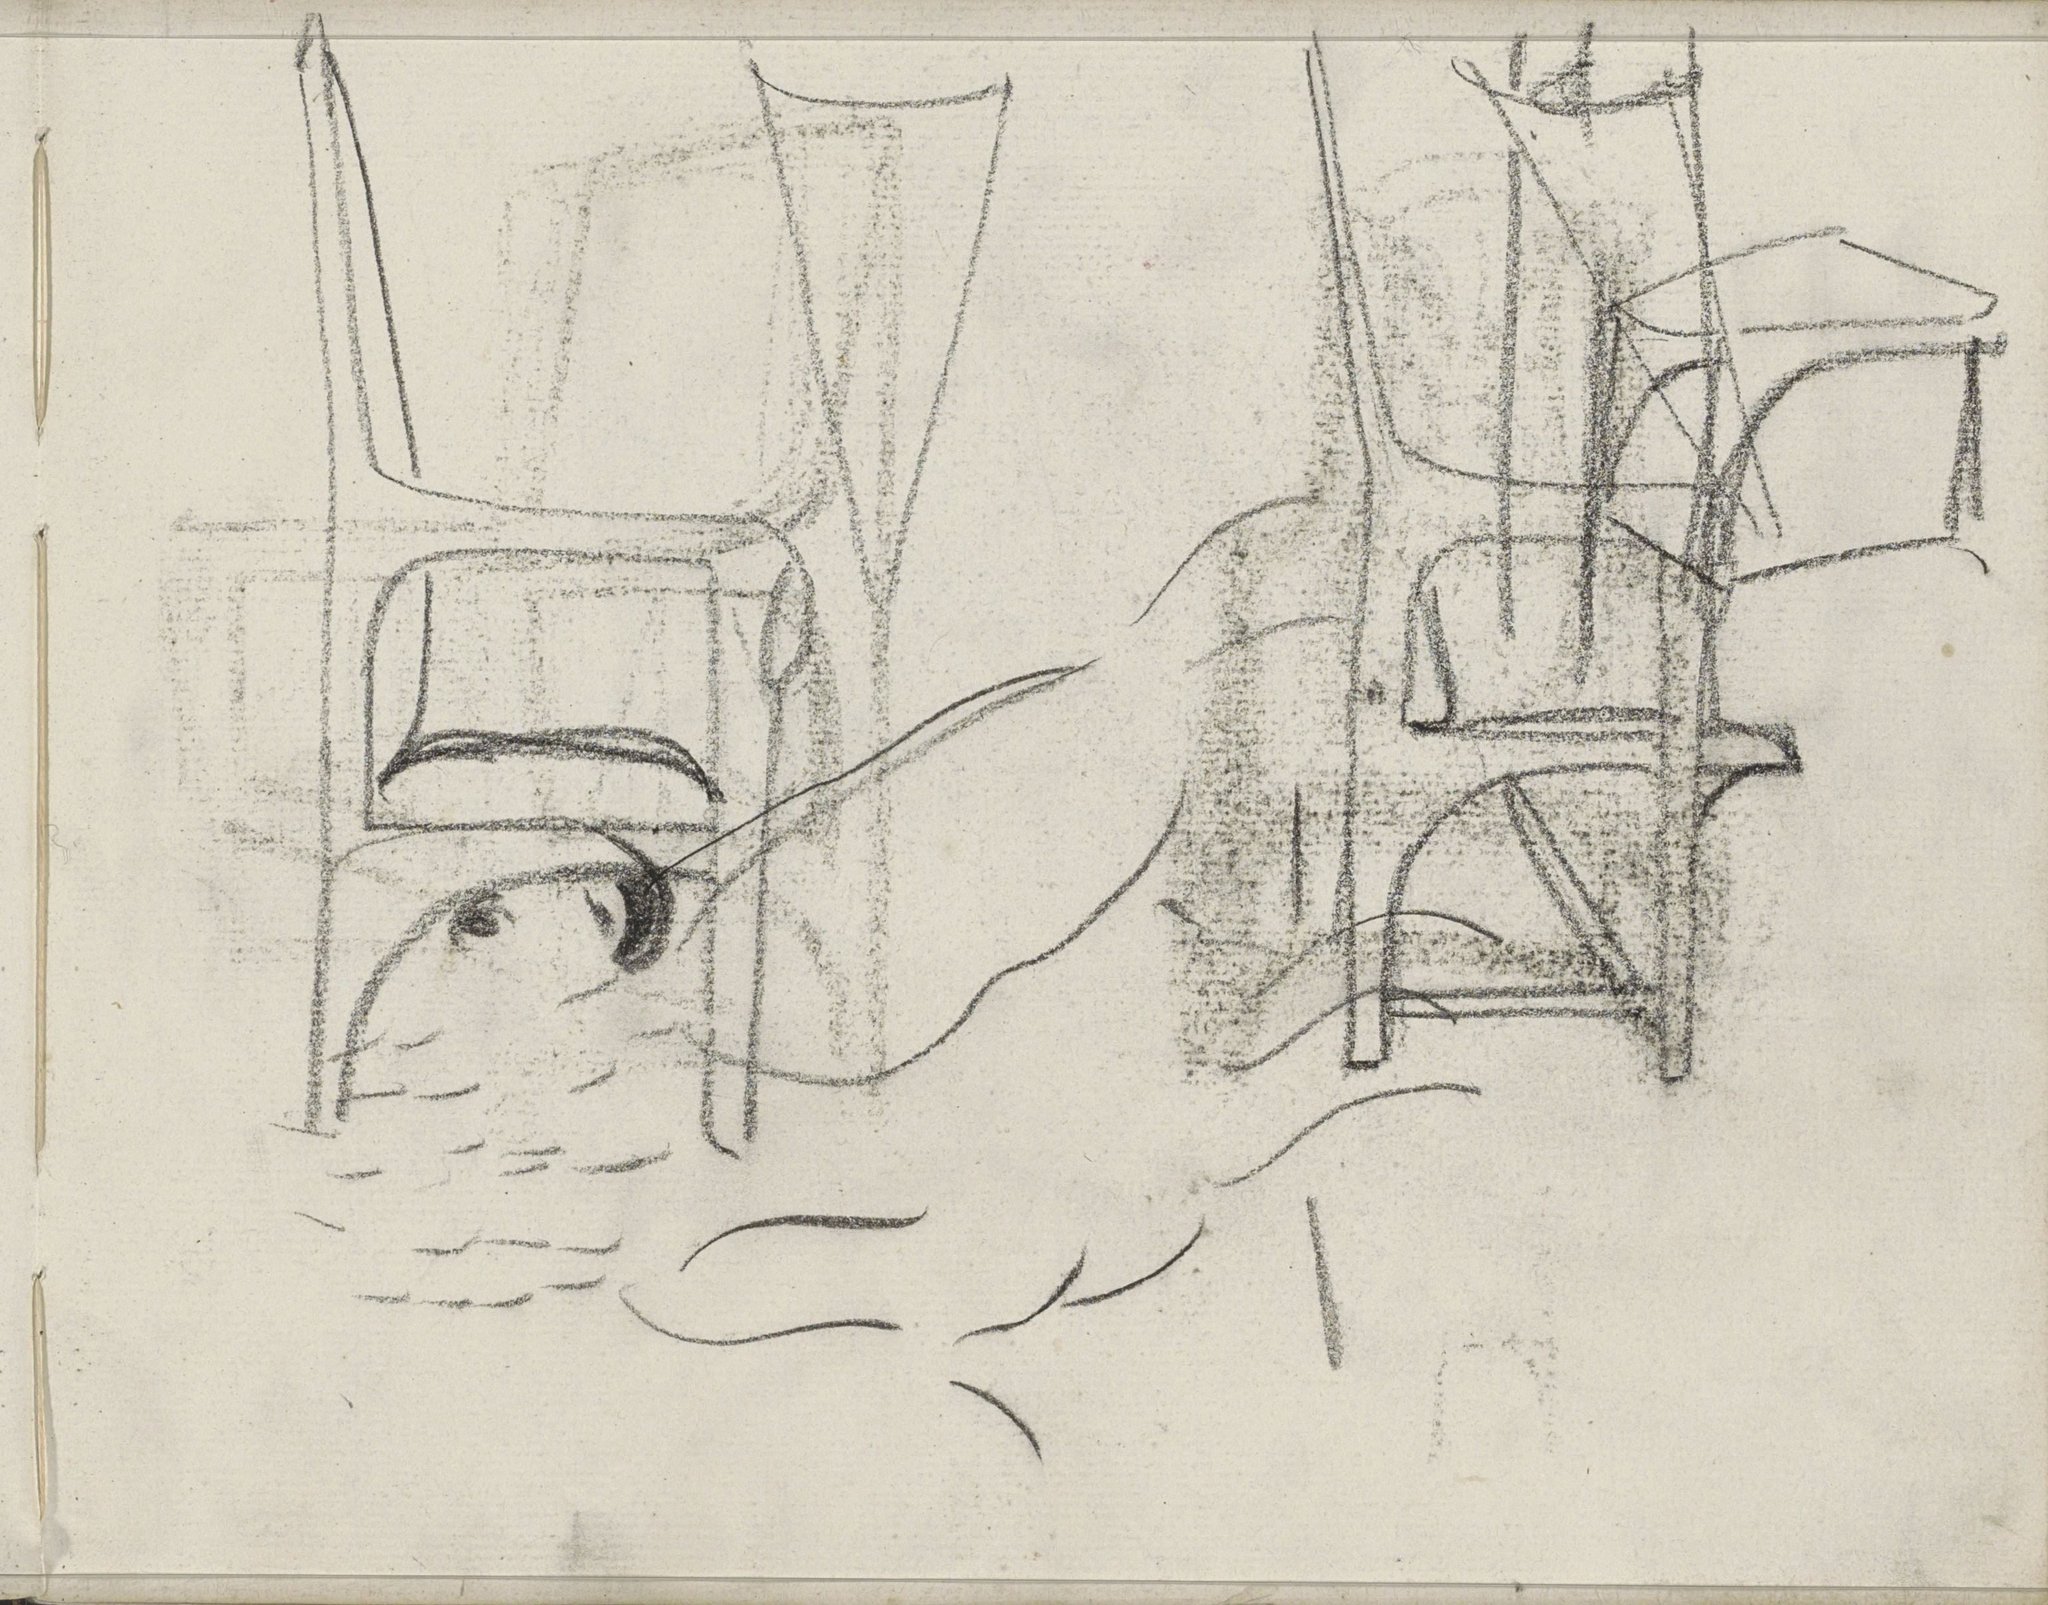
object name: sketchbook leaf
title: Ontwerpen voor een stoel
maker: carel adolph lion cachet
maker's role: draughtsman, print maker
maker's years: 1864-1945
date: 1896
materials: chalk, paper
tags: chair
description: Blad 4 recto uit een schetsboek met 44 bladen.